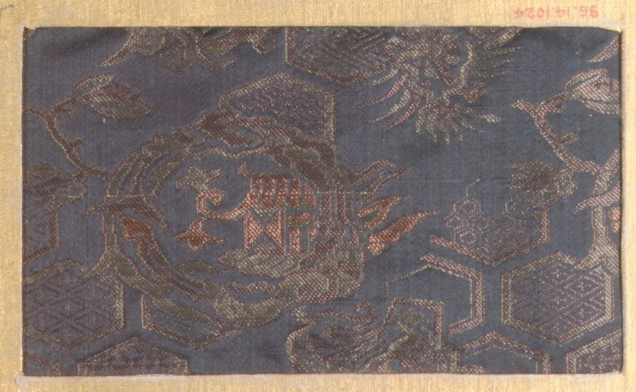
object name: piece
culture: japanese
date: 1701-1900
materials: silk